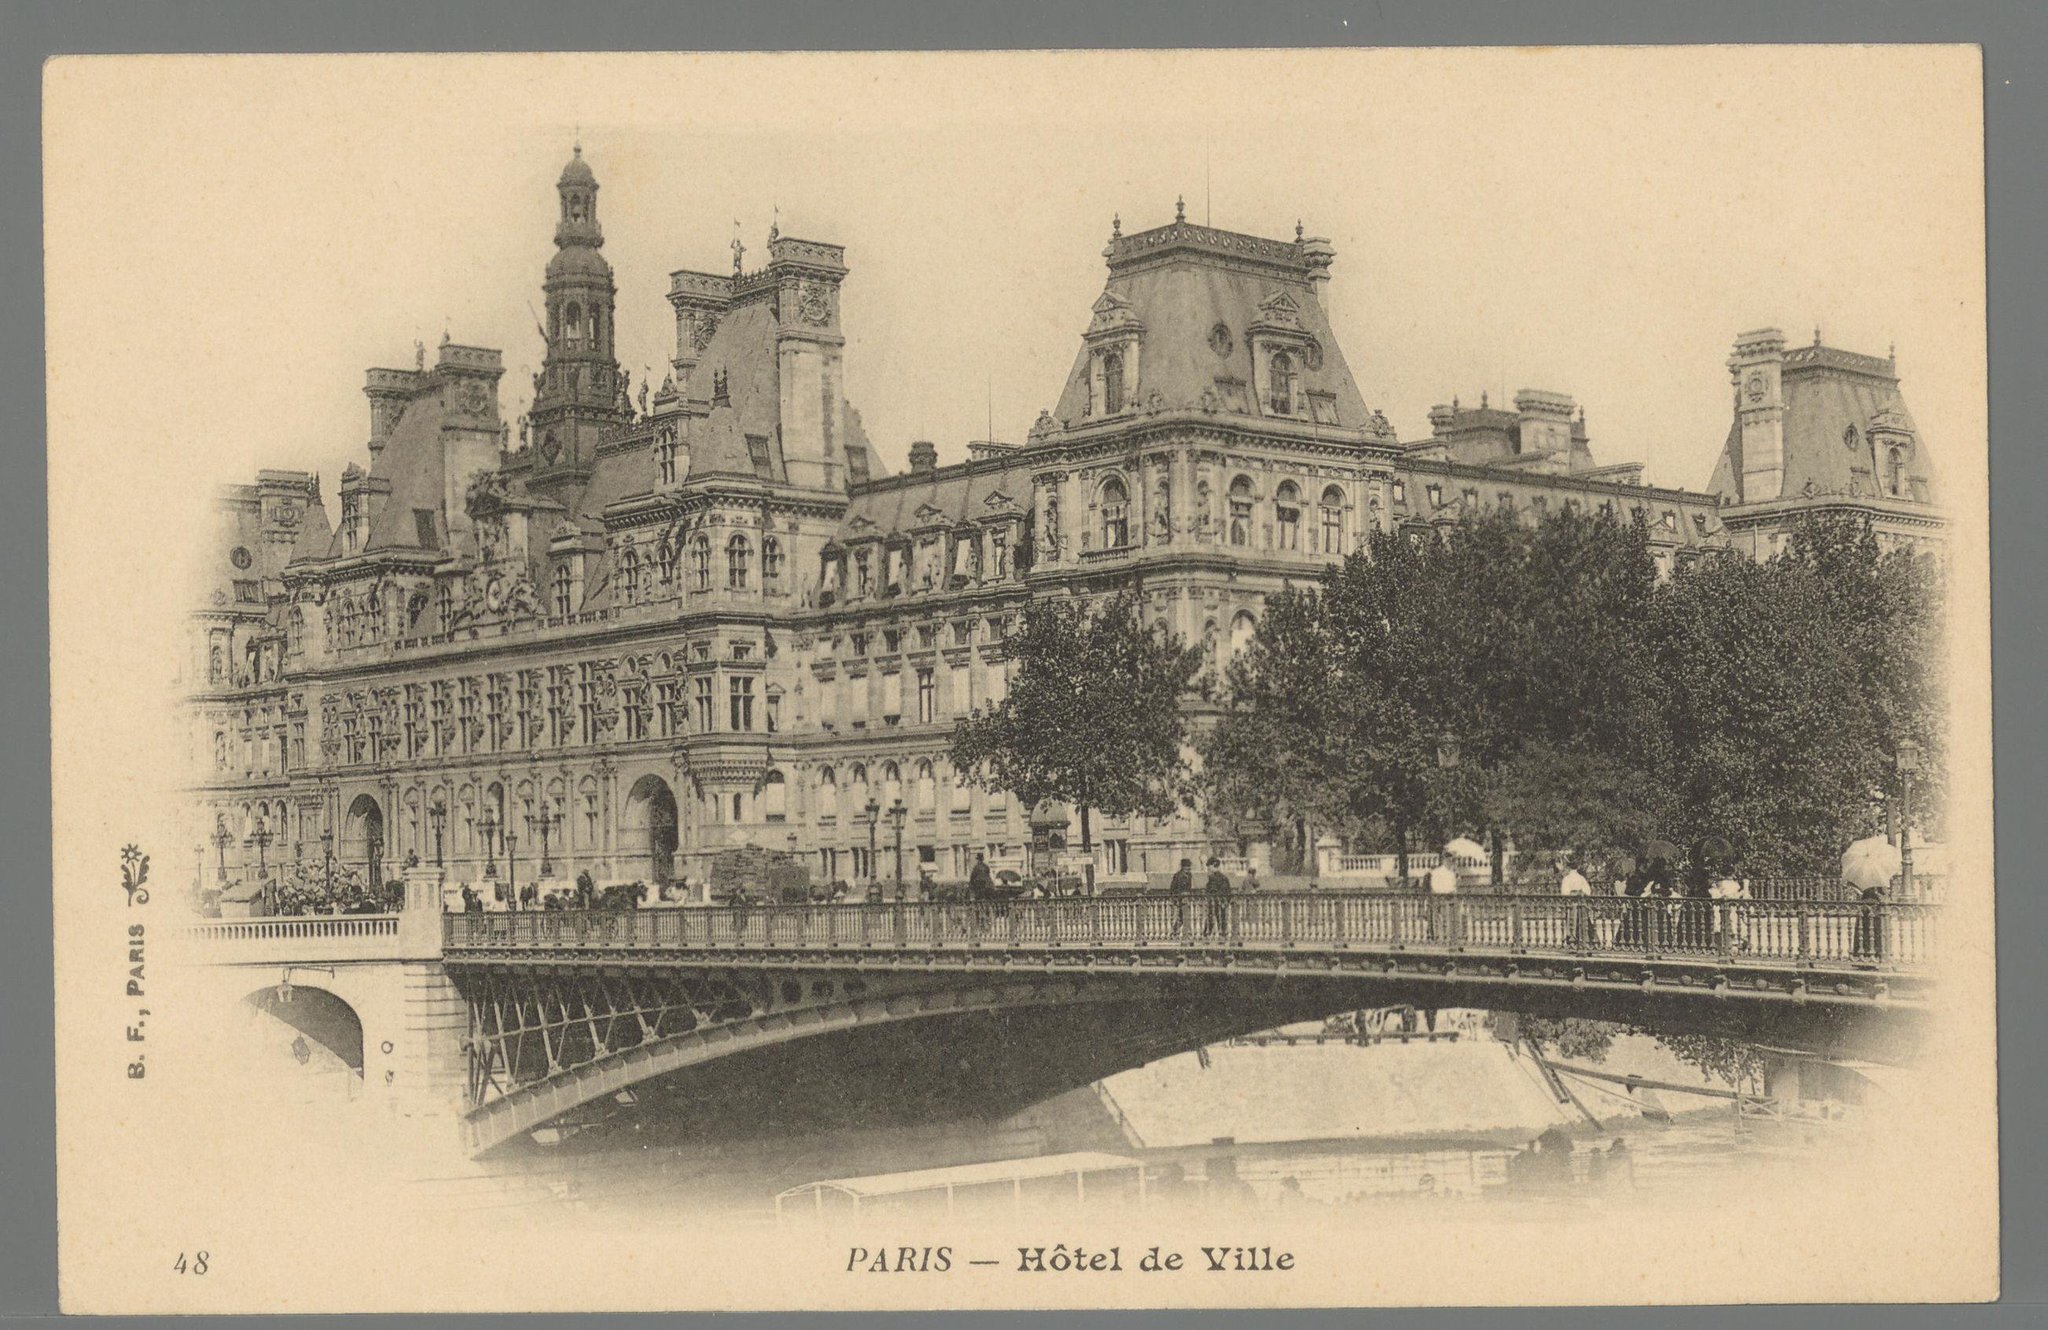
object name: ansichtkaart, prentbriefkaart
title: Paris. Hôtel de Ville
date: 1892-1904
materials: cardboard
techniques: photograph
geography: paris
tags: townhall, city-view, and landscape with man-made constructions (+ city(-scape) with figures, staffage)